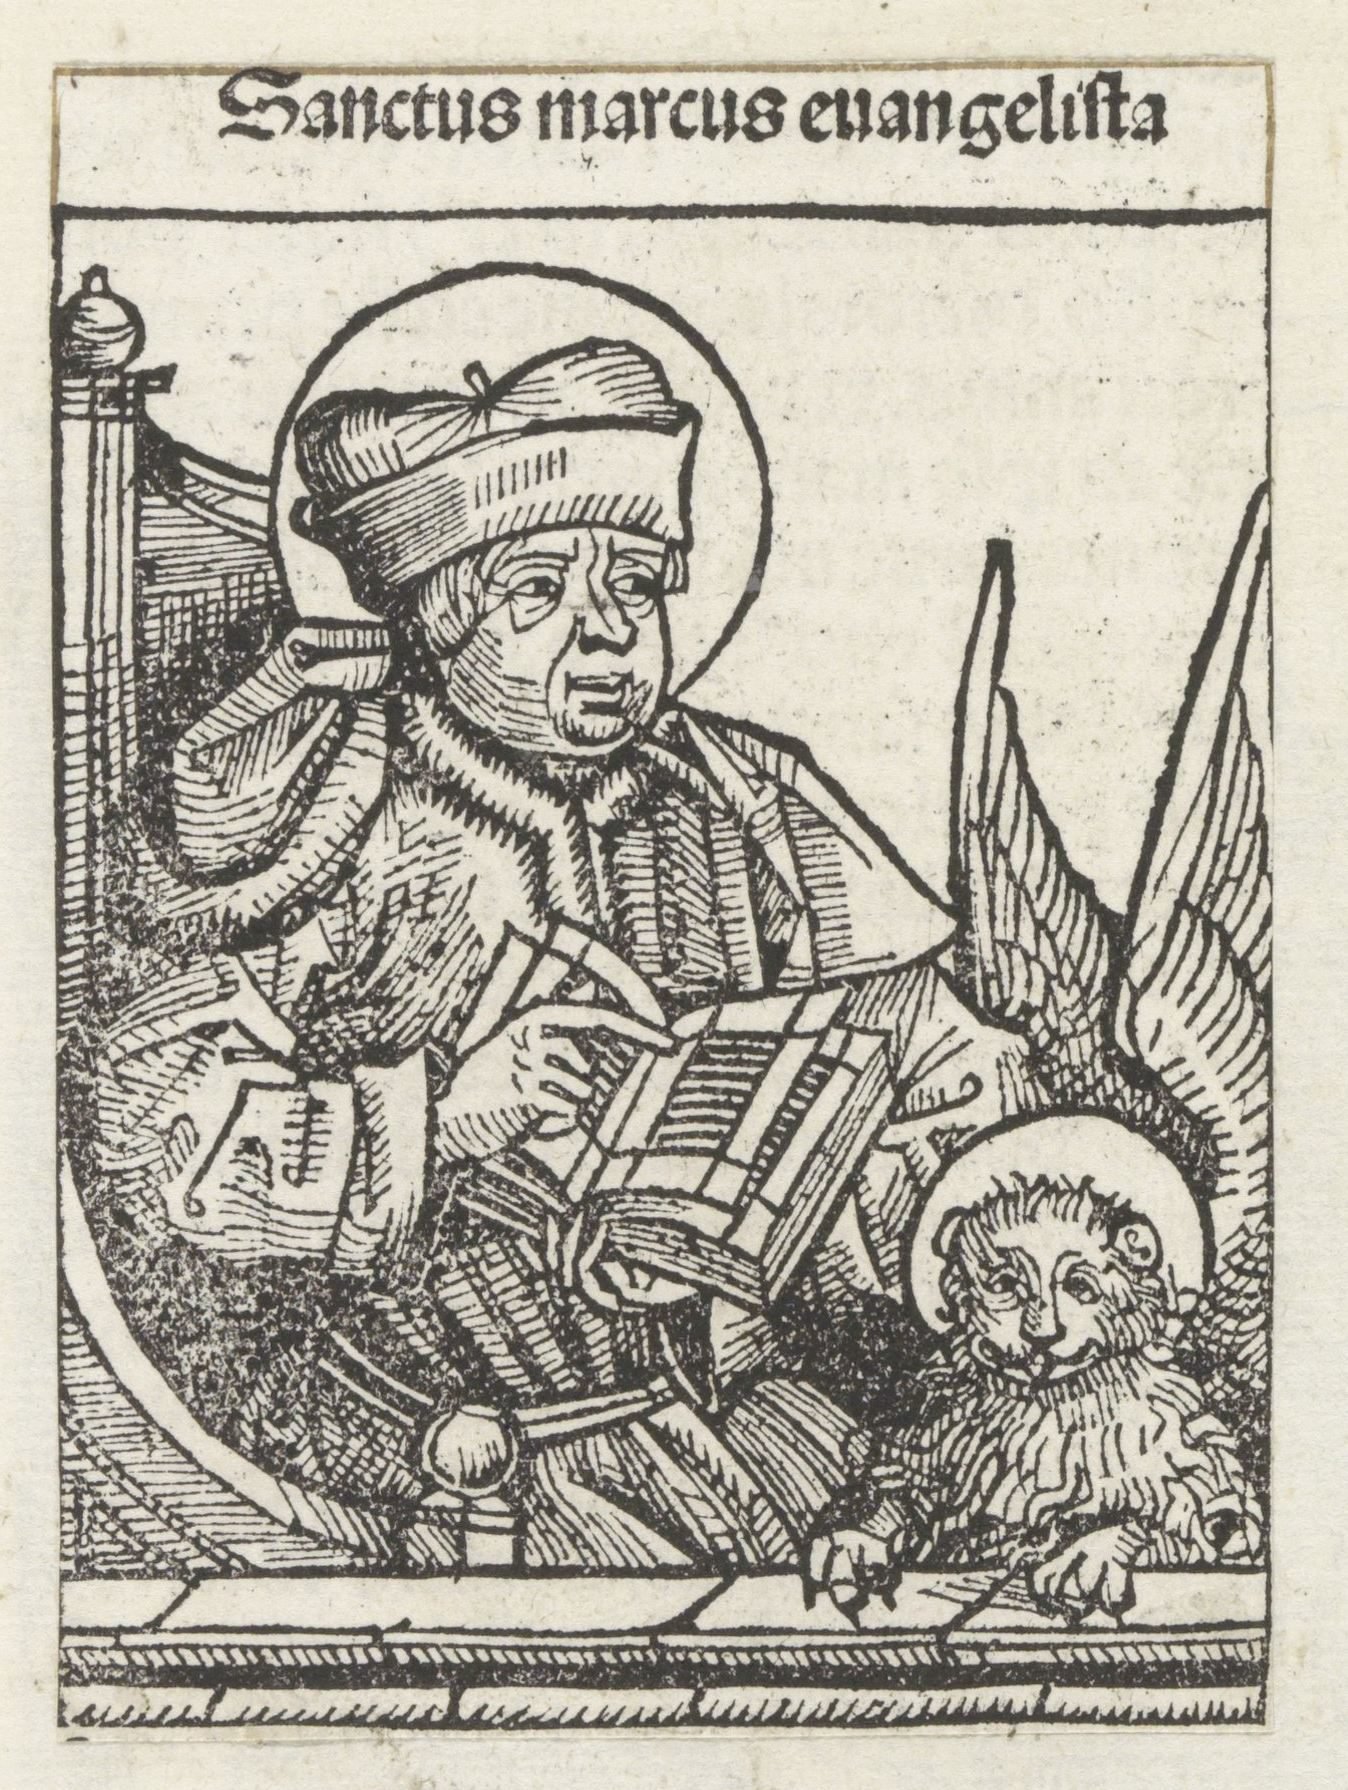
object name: book illustration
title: Sanctus marcus evangelista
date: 1493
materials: paper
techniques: letterpress printing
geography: nuremberg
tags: mark (marcus) the evangelist, and bishop of alexandria; possible attributes: book, (winged) lion, pen and inkhorn, scroll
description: De houtsnede wordt gebruikt als boekillustratie in de Liber Chronicarum (of Neurenbergkroniek) van Hartmann Schedel, verschenen in het Latijn en Duits in 1493. Zie de Latijnse uitgave, folio 104r.